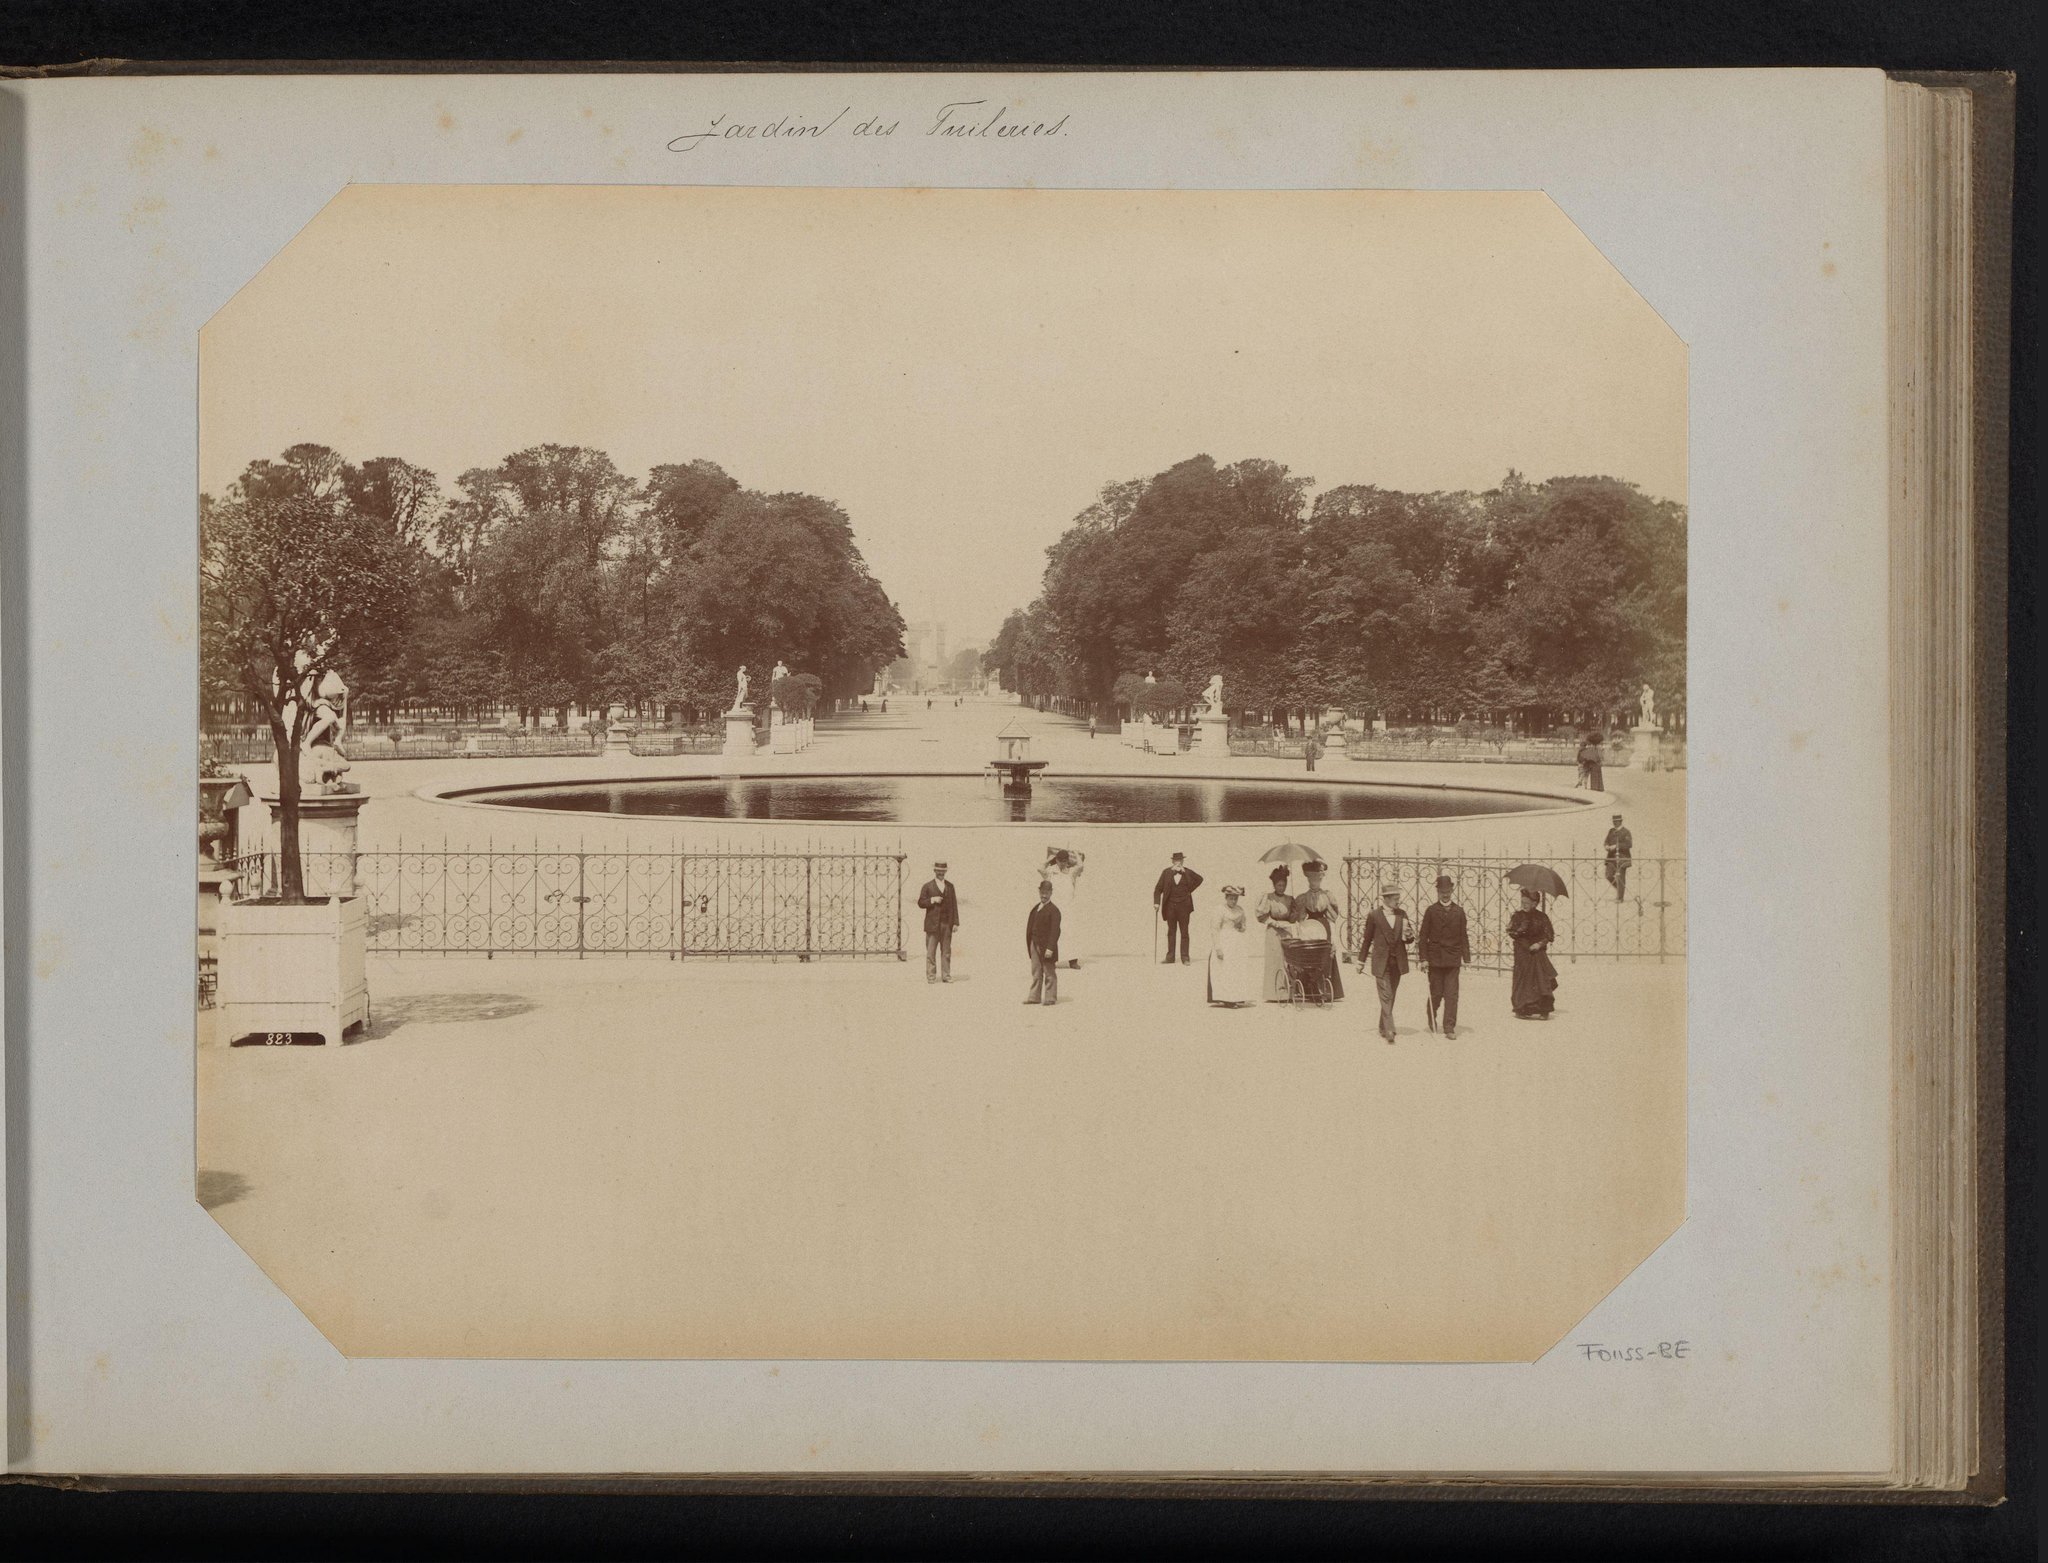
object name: photograph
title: Gezicht op de Jardin des Tuileries te Parijs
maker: Anonymous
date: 1890-1898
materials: photographic support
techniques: albumen print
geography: paris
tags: garden, paris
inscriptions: annotation: ‘Jardin des Tuileries’, retailer's mark: ‘E. Hautecoeur/ Estampes Photographies/ 35 Avenue de l'Opéra, 35/ Paris’